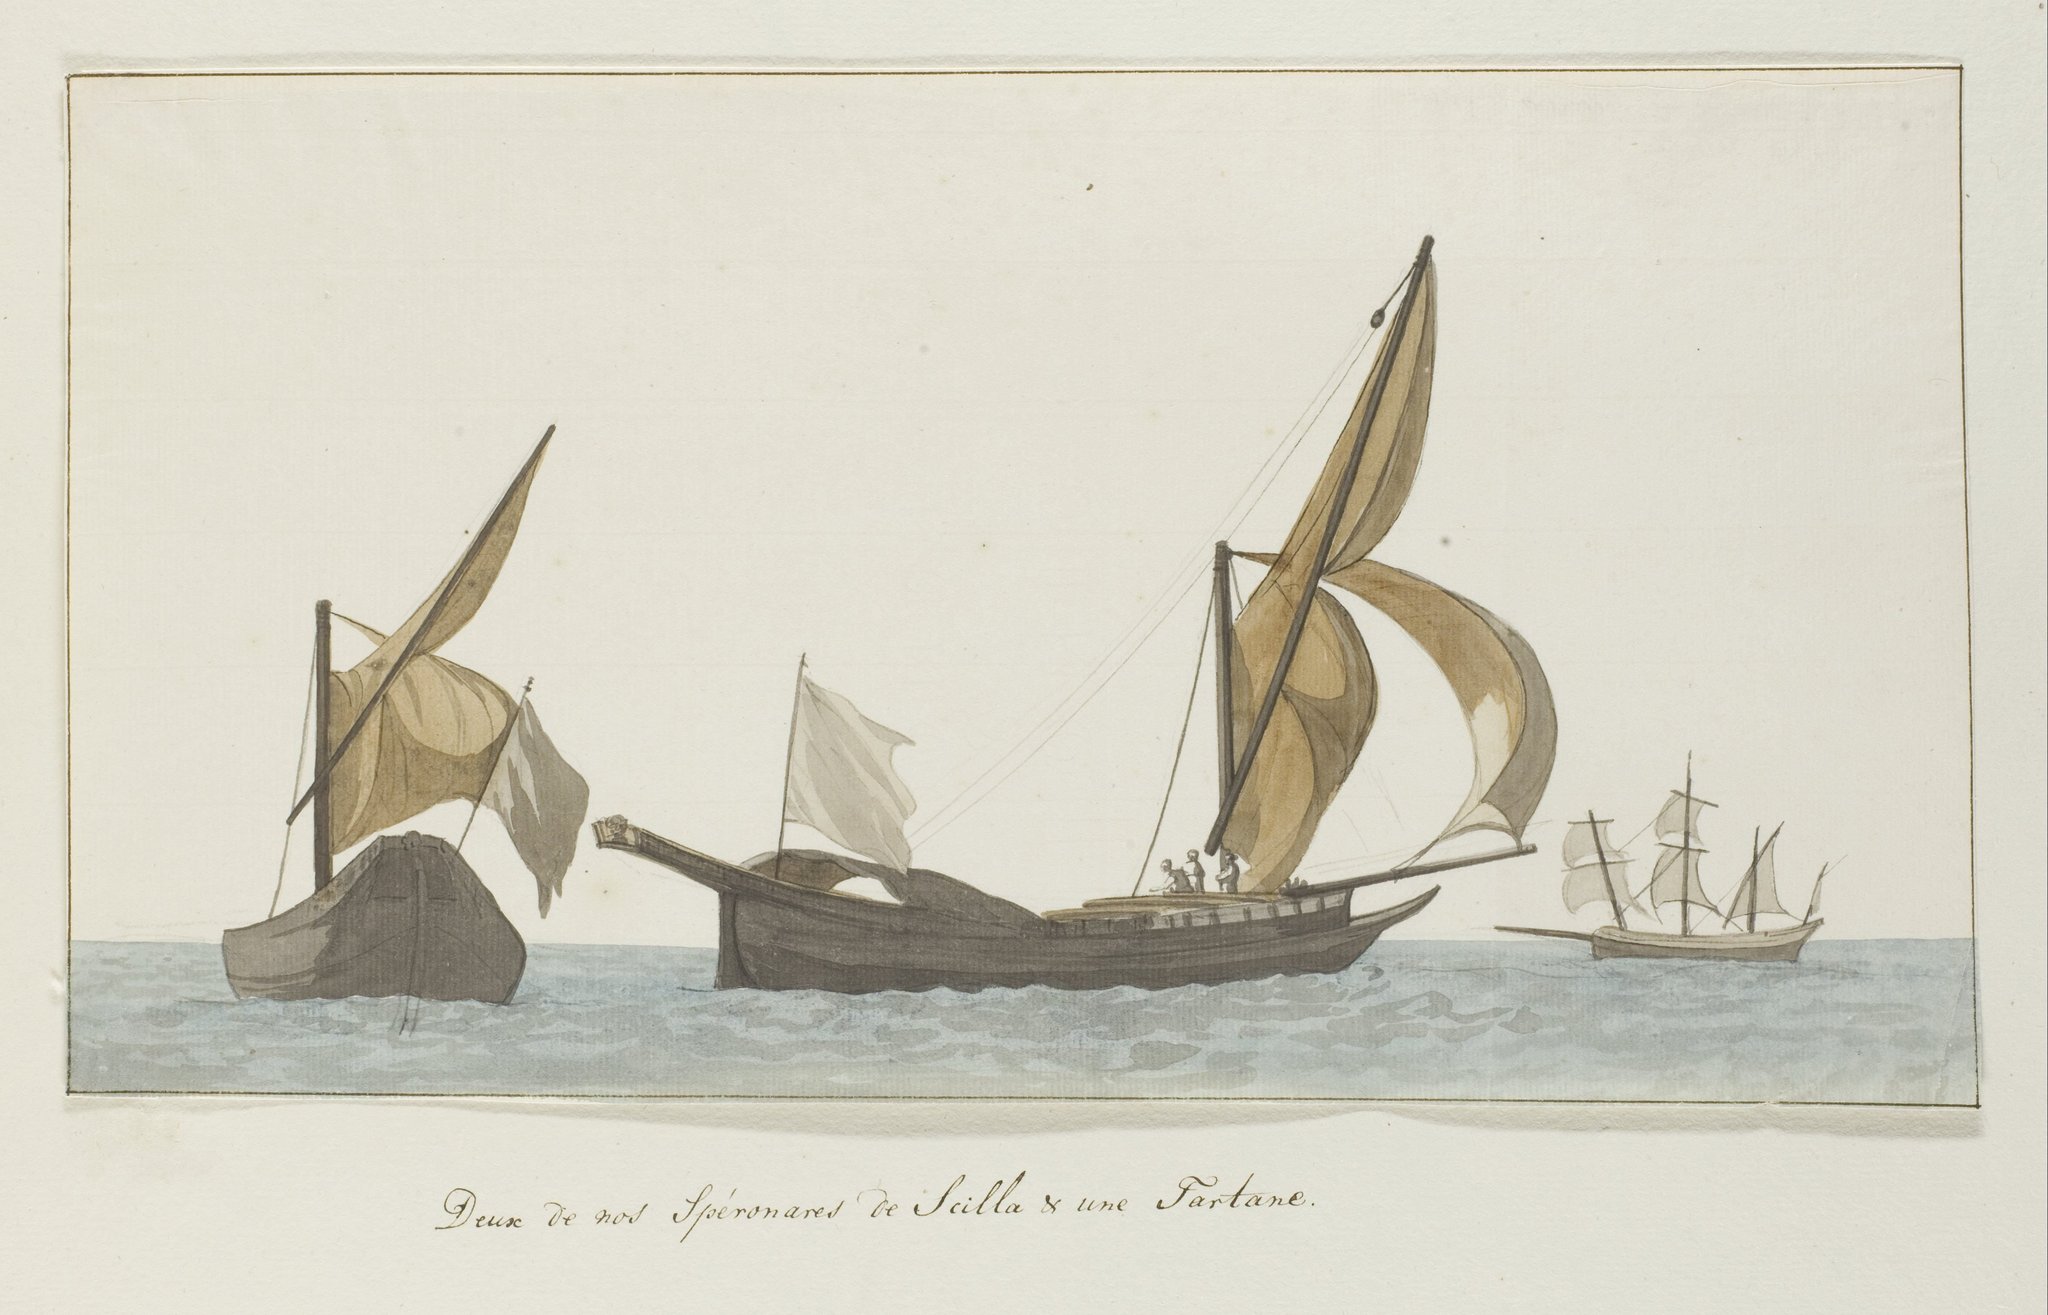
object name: drawing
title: Deux de nos Spéronares de Scilla & une Tartane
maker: louis ducros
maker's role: draughtsman, print maker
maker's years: 1748-1810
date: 1778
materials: chalk, paper, watercolor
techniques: brush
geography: sicily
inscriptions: number: ‘No 152 Deux de nos Spéronares de Scilla & une Tartane’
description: Tekening uit het album 'Voyage en Italie, en Sicile et à Malte', 1778.